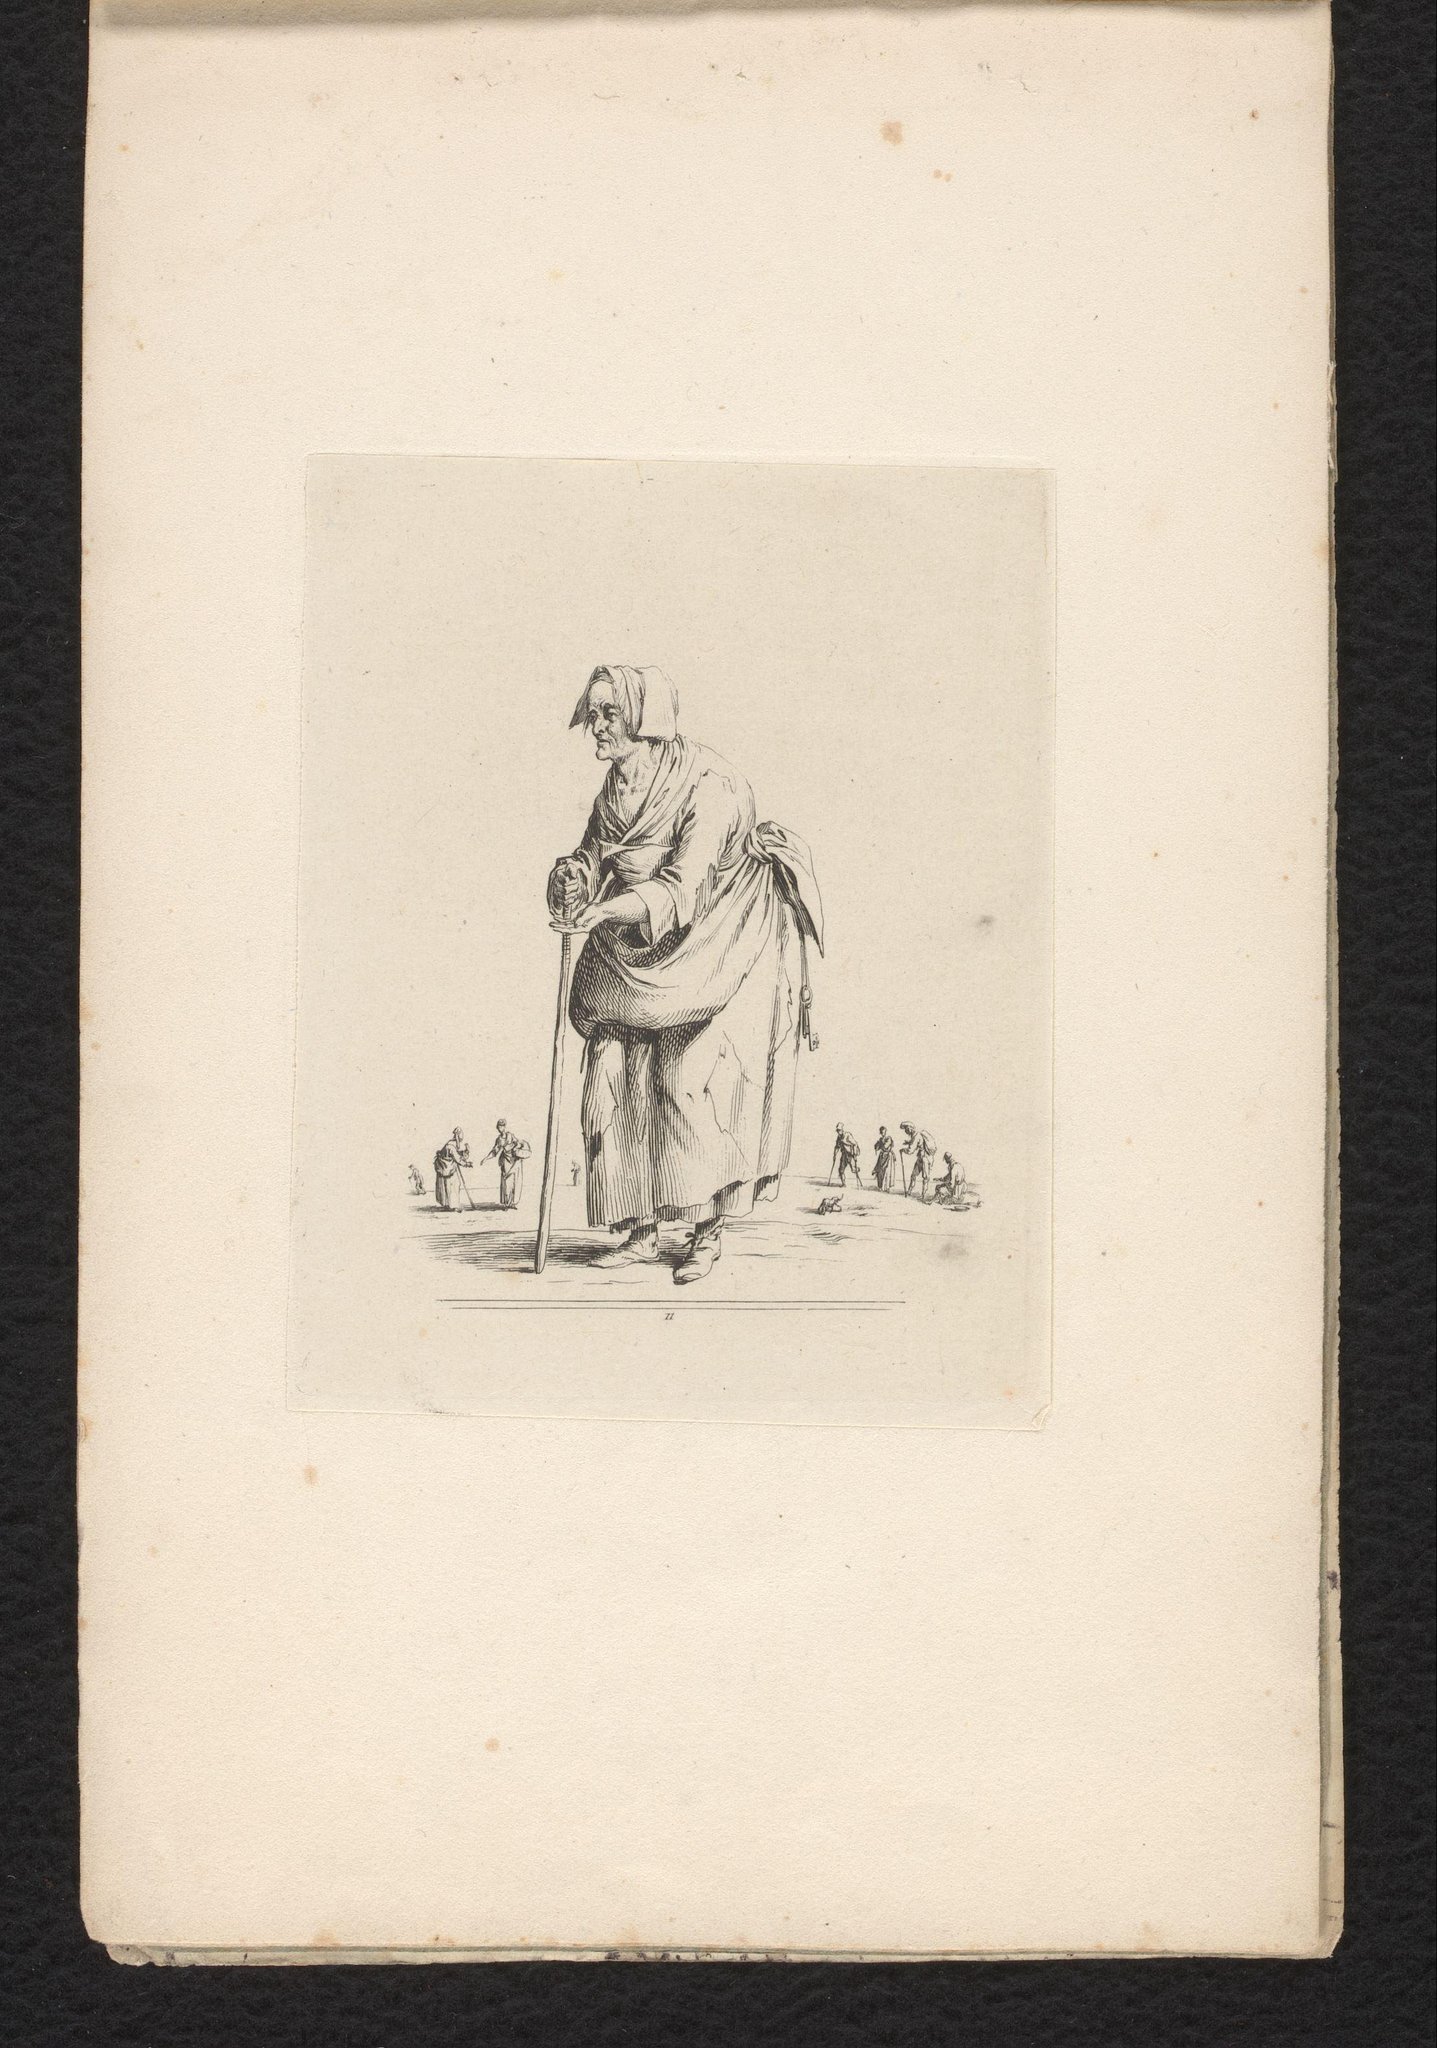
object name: album leaf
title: Bedelaars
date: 1798-1806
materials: paper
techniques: engraving, etching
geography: paris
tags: clothed in rags, old woman, beggar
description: Staande oude bedelares met stok die haar hand ophoudt. Prent maakt deel uit van een album.